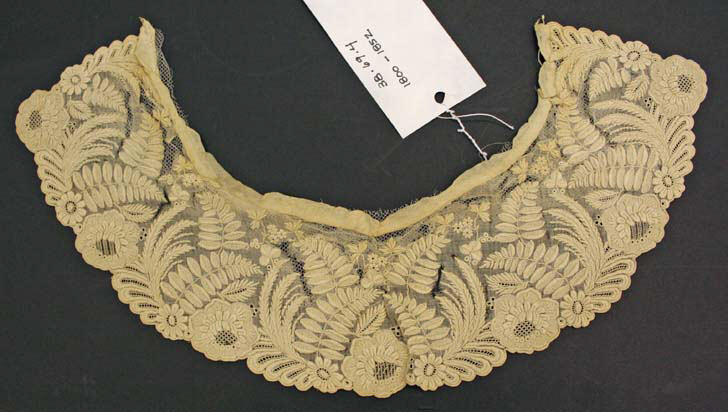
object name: collar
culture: american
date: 1845-1850